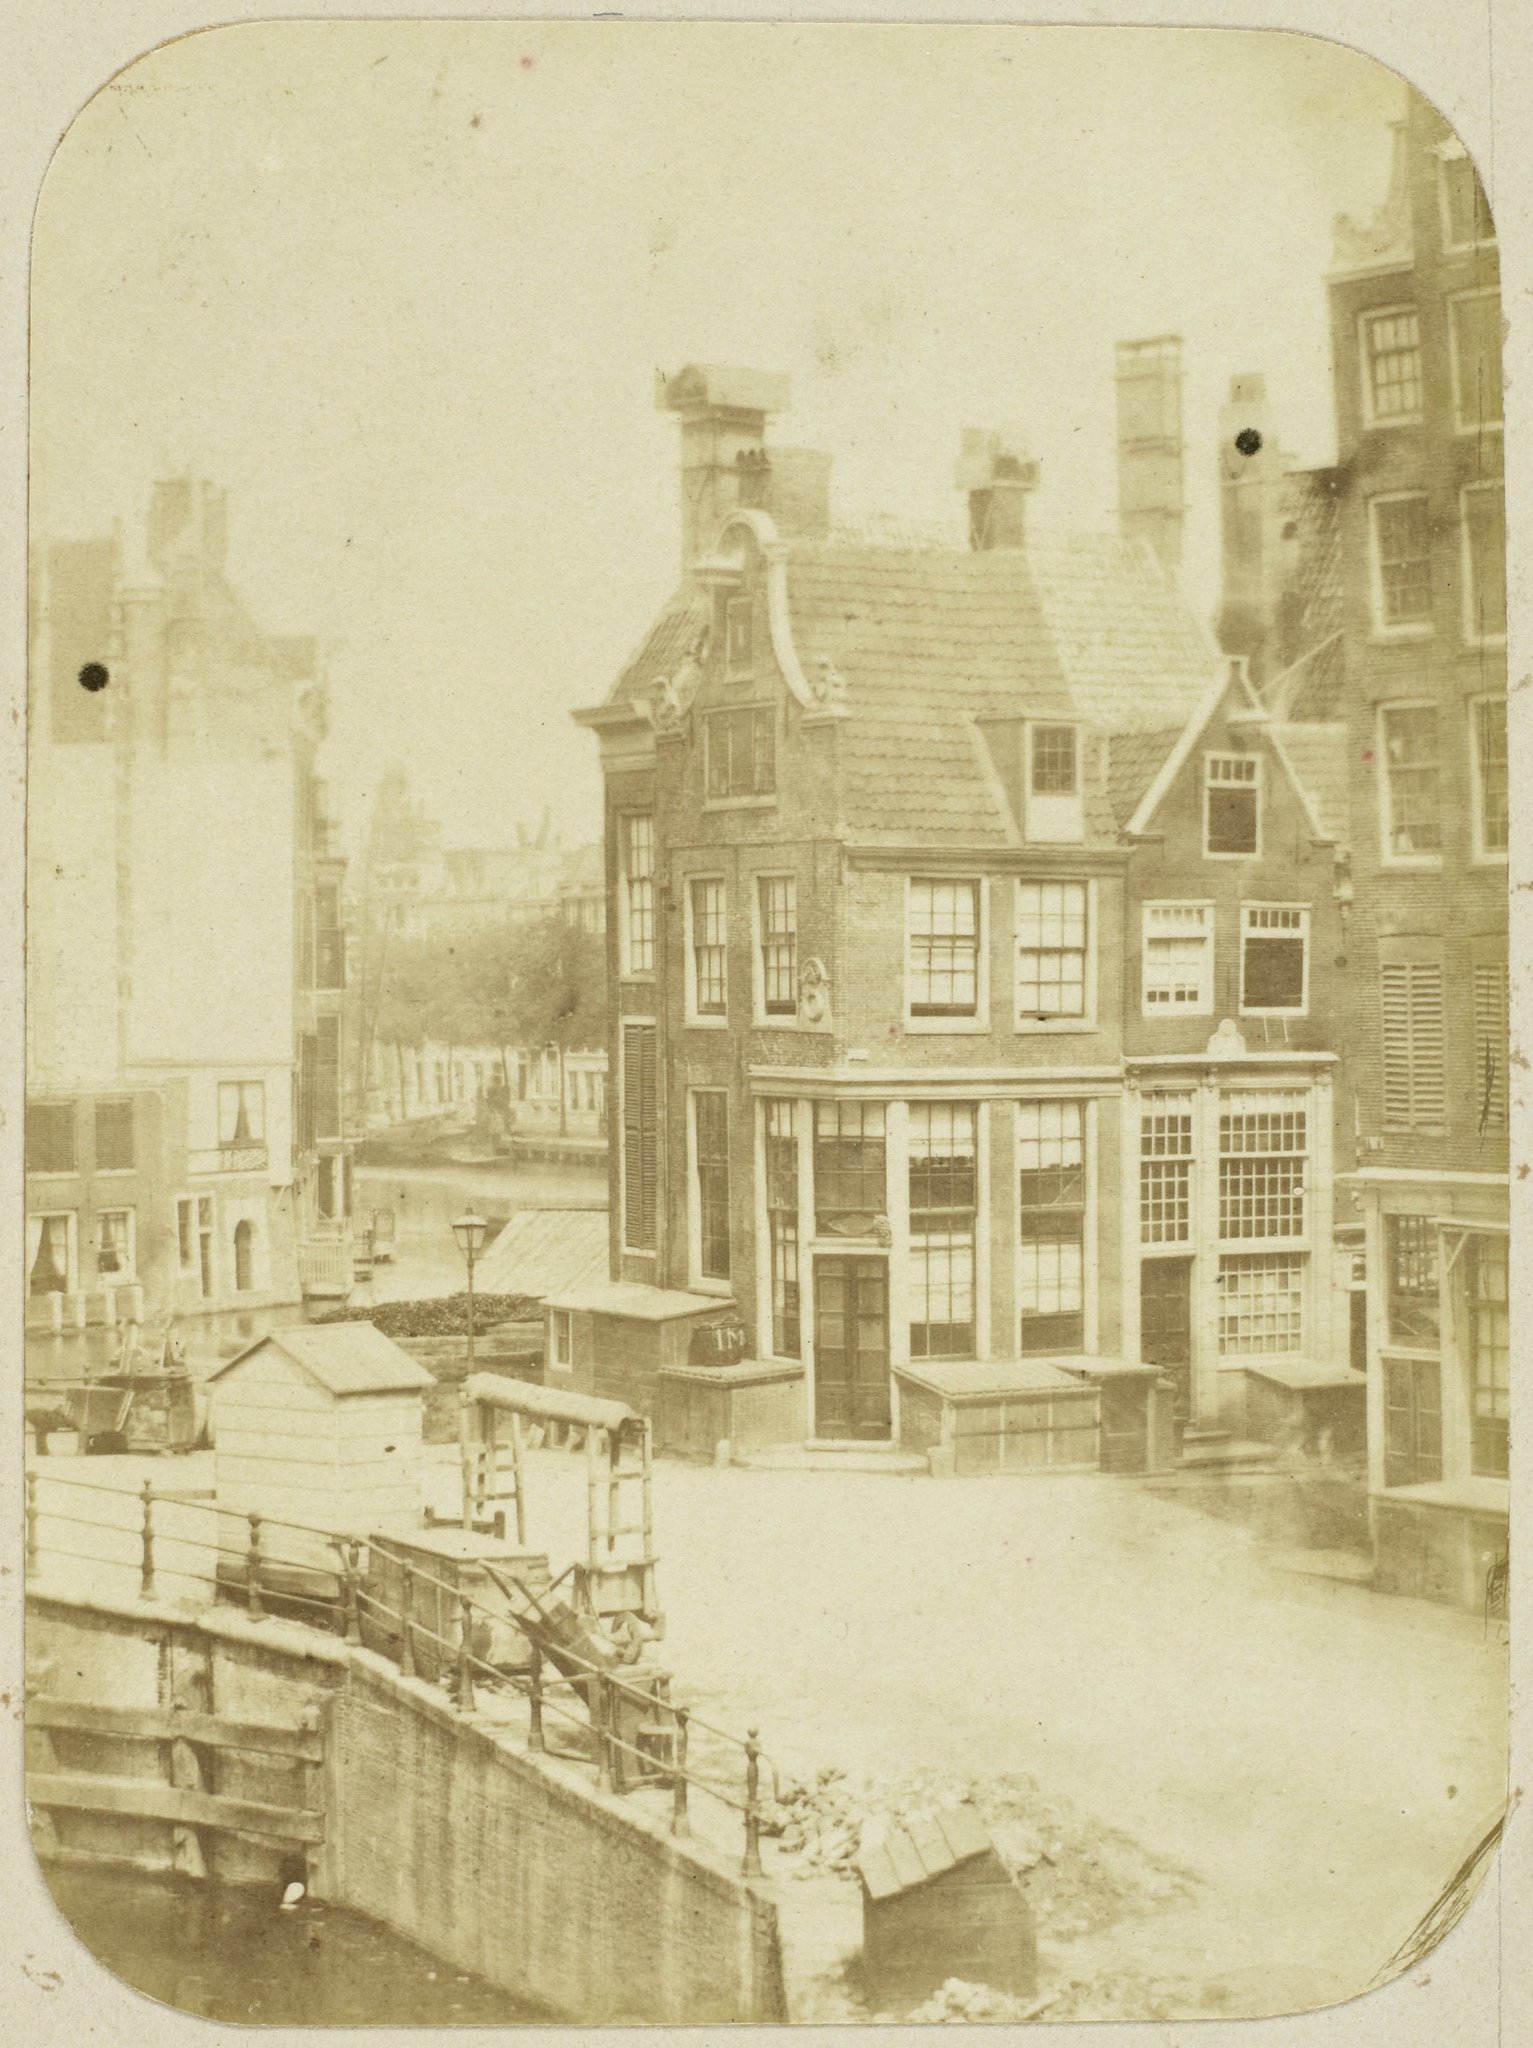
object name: photograph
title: Gezicht op de hoek van het Muntplein en de Reguliersbreestraat in Amsterdam vanuit het huis van de fotograaf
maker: eduard isaac asser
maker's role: amateurfotograaf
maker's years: 1809-1894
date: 1852-1857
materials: cardboard, paper, photographic support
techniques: salted paper print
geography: amsterdam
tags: muntplein (amsterdam), singel, reguliersbreestraat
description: Uitzicht uit het huis van de fotograaf, Singel 548, naar de ingang van de Reguliersbreestraat met geheel rechts het hoekhuis Reguliersbreestraat 2 en aan de overkant van de straat de nummers 3 en 1. Uiterst links is een gedeelte van Logement Rondeel te zien.